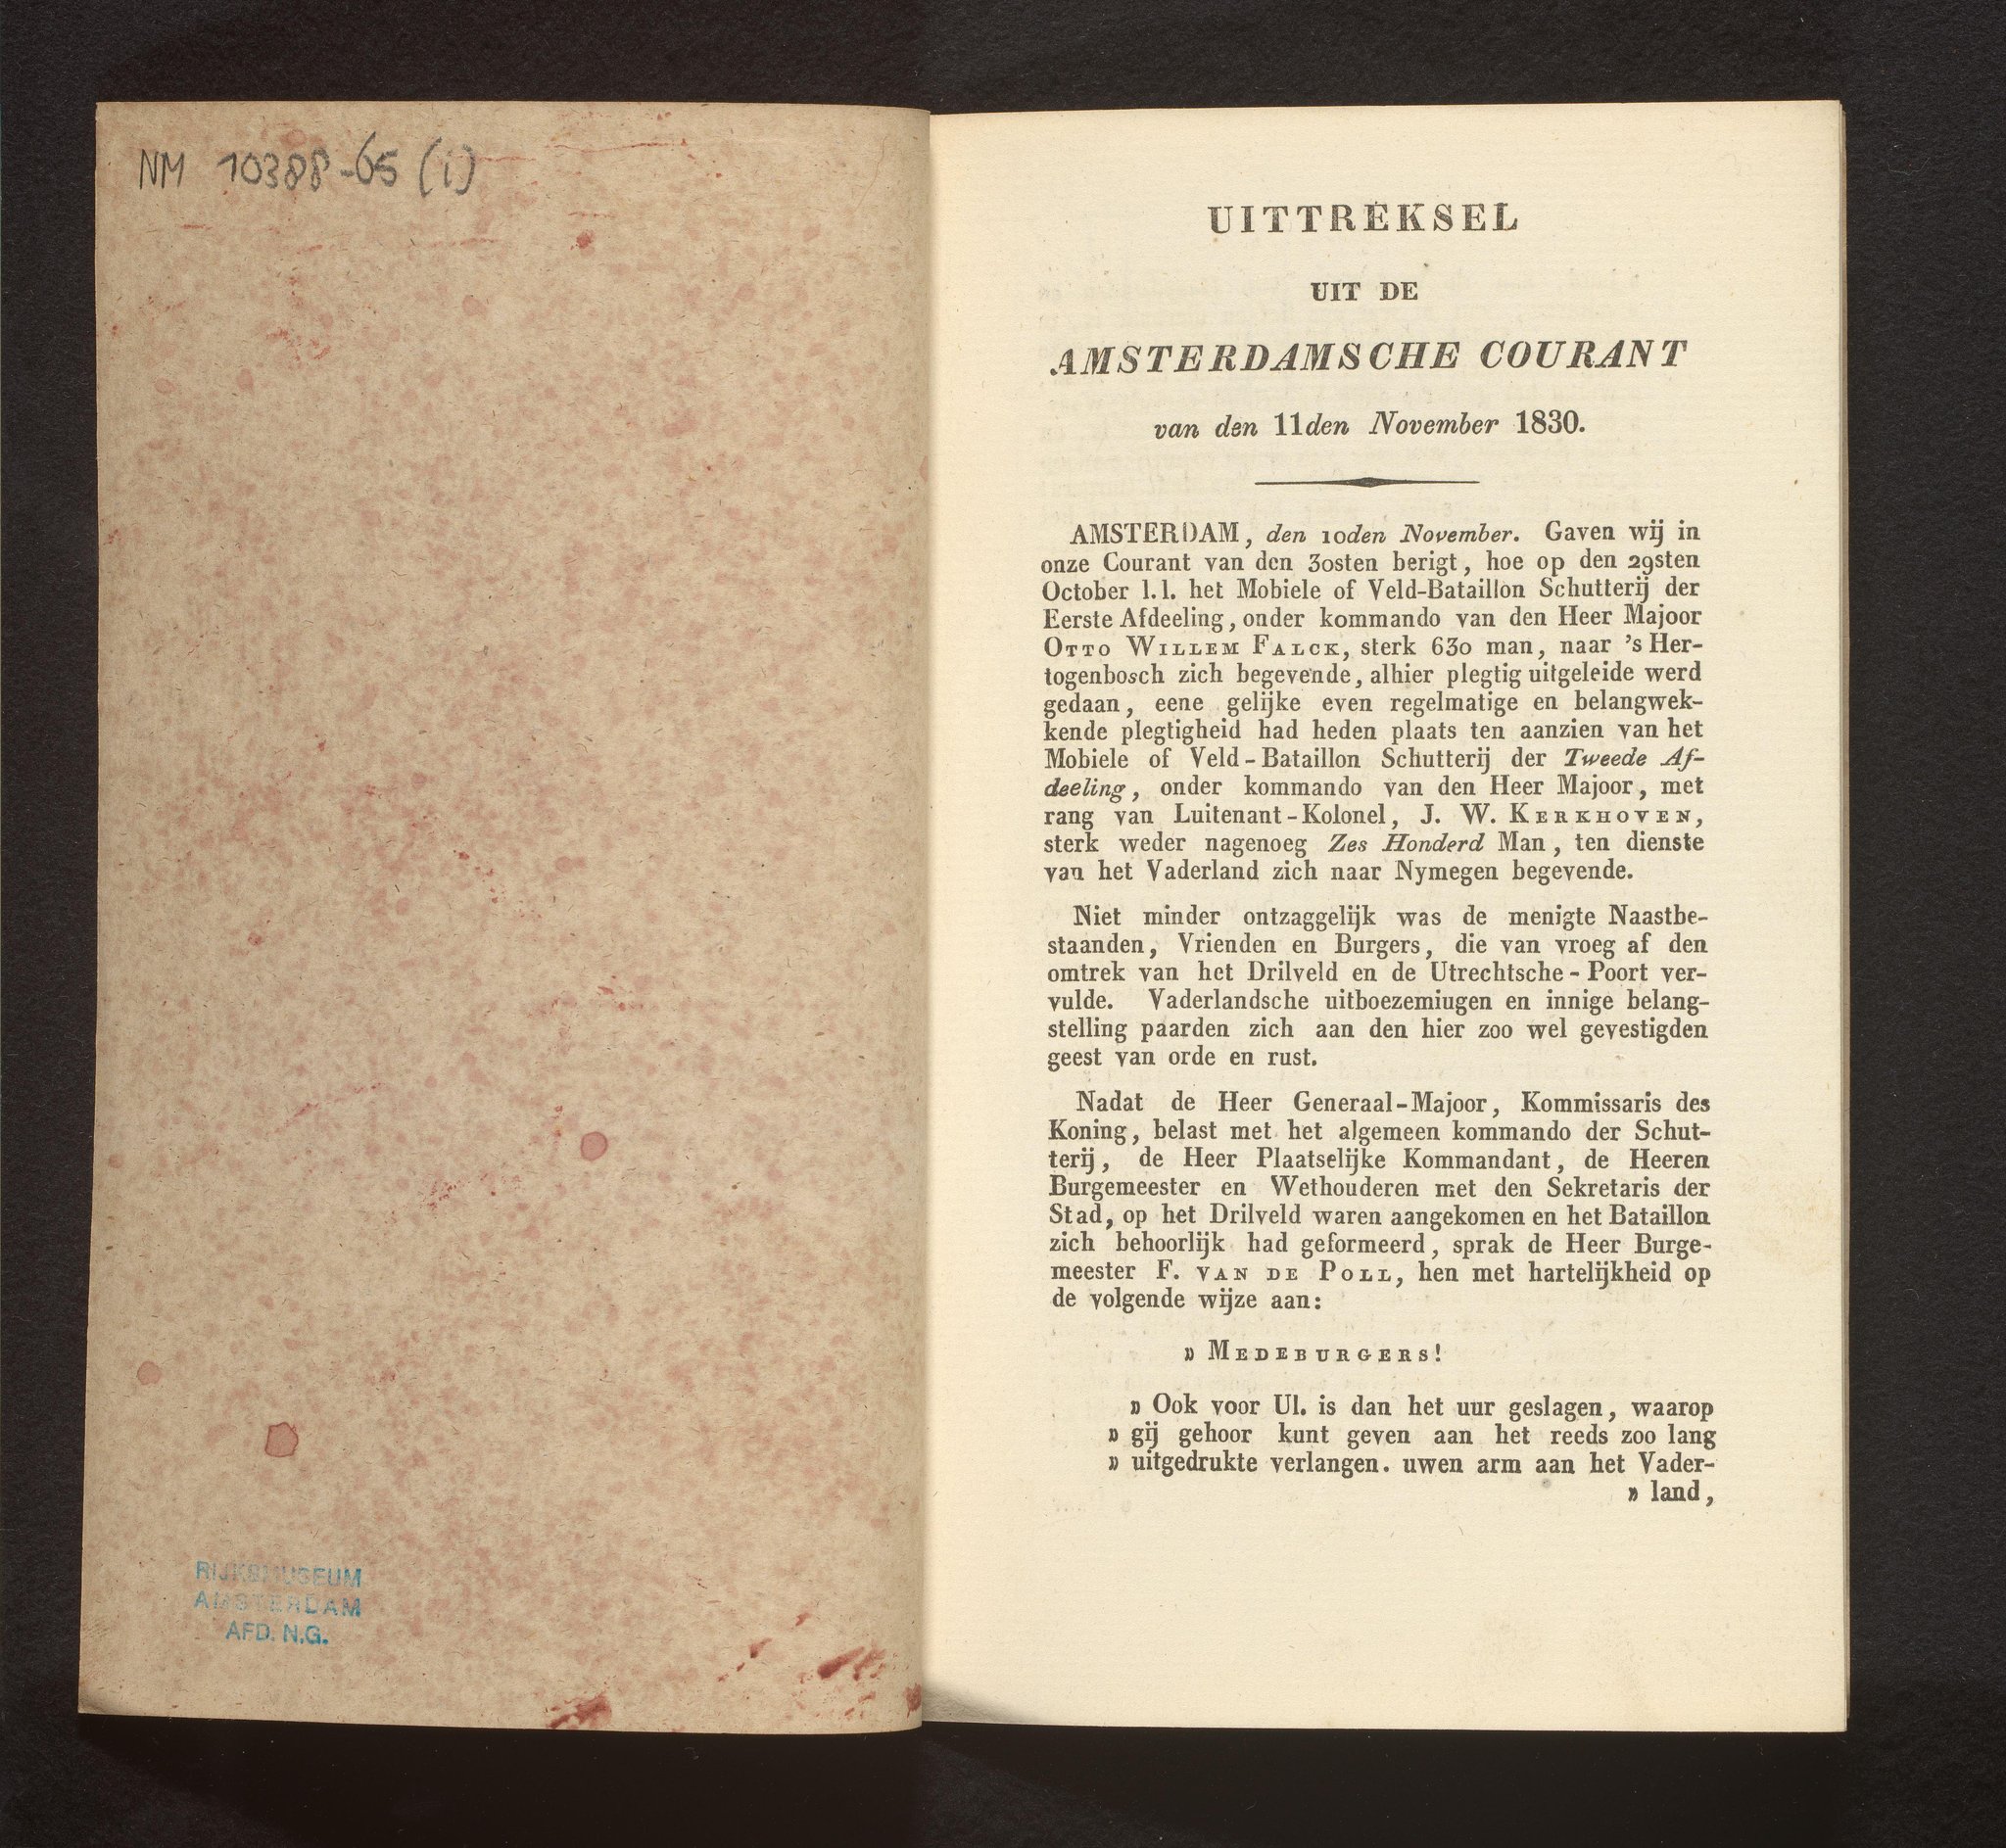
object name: brochure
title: Uittreksel uit de Amsterdamsche Courant van den 11 den November 1830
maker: Anonymous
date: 1830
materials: paper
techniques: brocade, printing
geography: amsterdam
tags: amsterdam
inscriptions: date